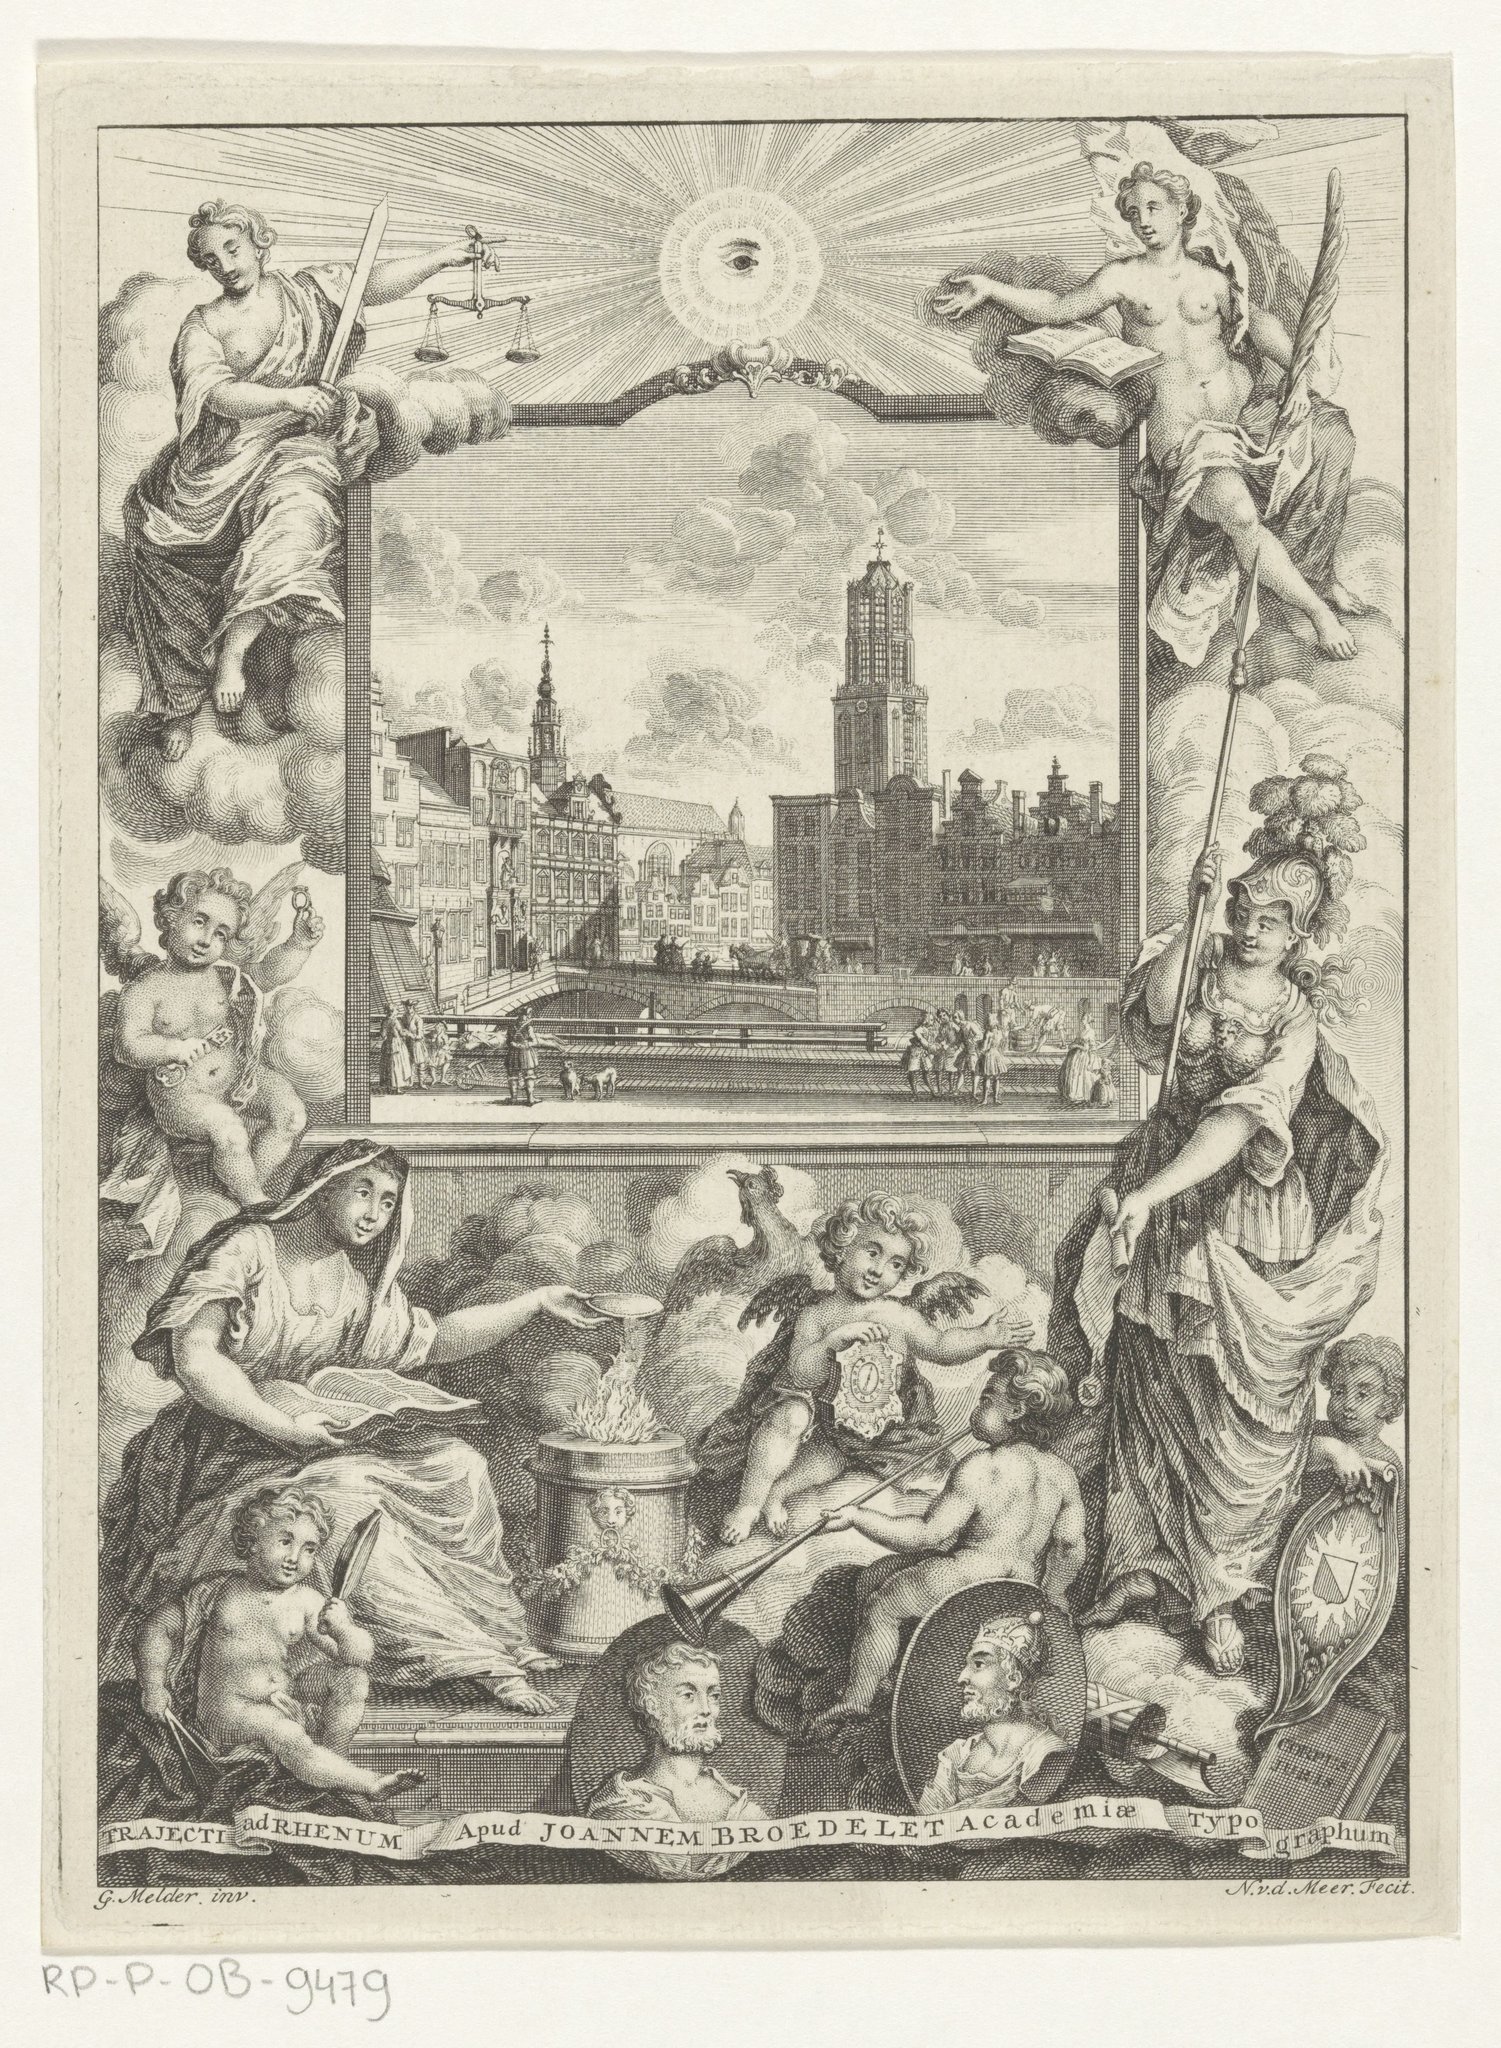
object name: titelblad, titelpagina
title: Stadsgezicht met Domkerk te Utrecht en allegorie met Utrechtse stedenmaagd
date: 1745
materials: paper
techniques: etching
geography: utrecht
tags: justice, 'justitia'; 'giustitia divina' (ripa) ~ one of the four cardinal virtues, personification of a city, town-patron(ess), 'historia'; 'historia' (ripa), utrecht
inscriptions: collector's mark: Lugt 2228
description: Een stadsgezicht met de Domkerk te Utrecht staat centraal in een omlijsting bekroond door het alziend oog van God. Links boven op een wolk zit Rechtvaardigheid en rechts zit Geschiedenis met een boek en een schrijfveer. Rechts staat de Utrechtse stedenmaagd met een lans en een oorkonde met Utrechts zegel. Naast haar een putto met het wapenschild van de universiteit Utrecht. Links zit een allegorische figuur met een boek op haar schoot bij een brandende altaarzuil, wellicht het Geloof of de Matigheid.